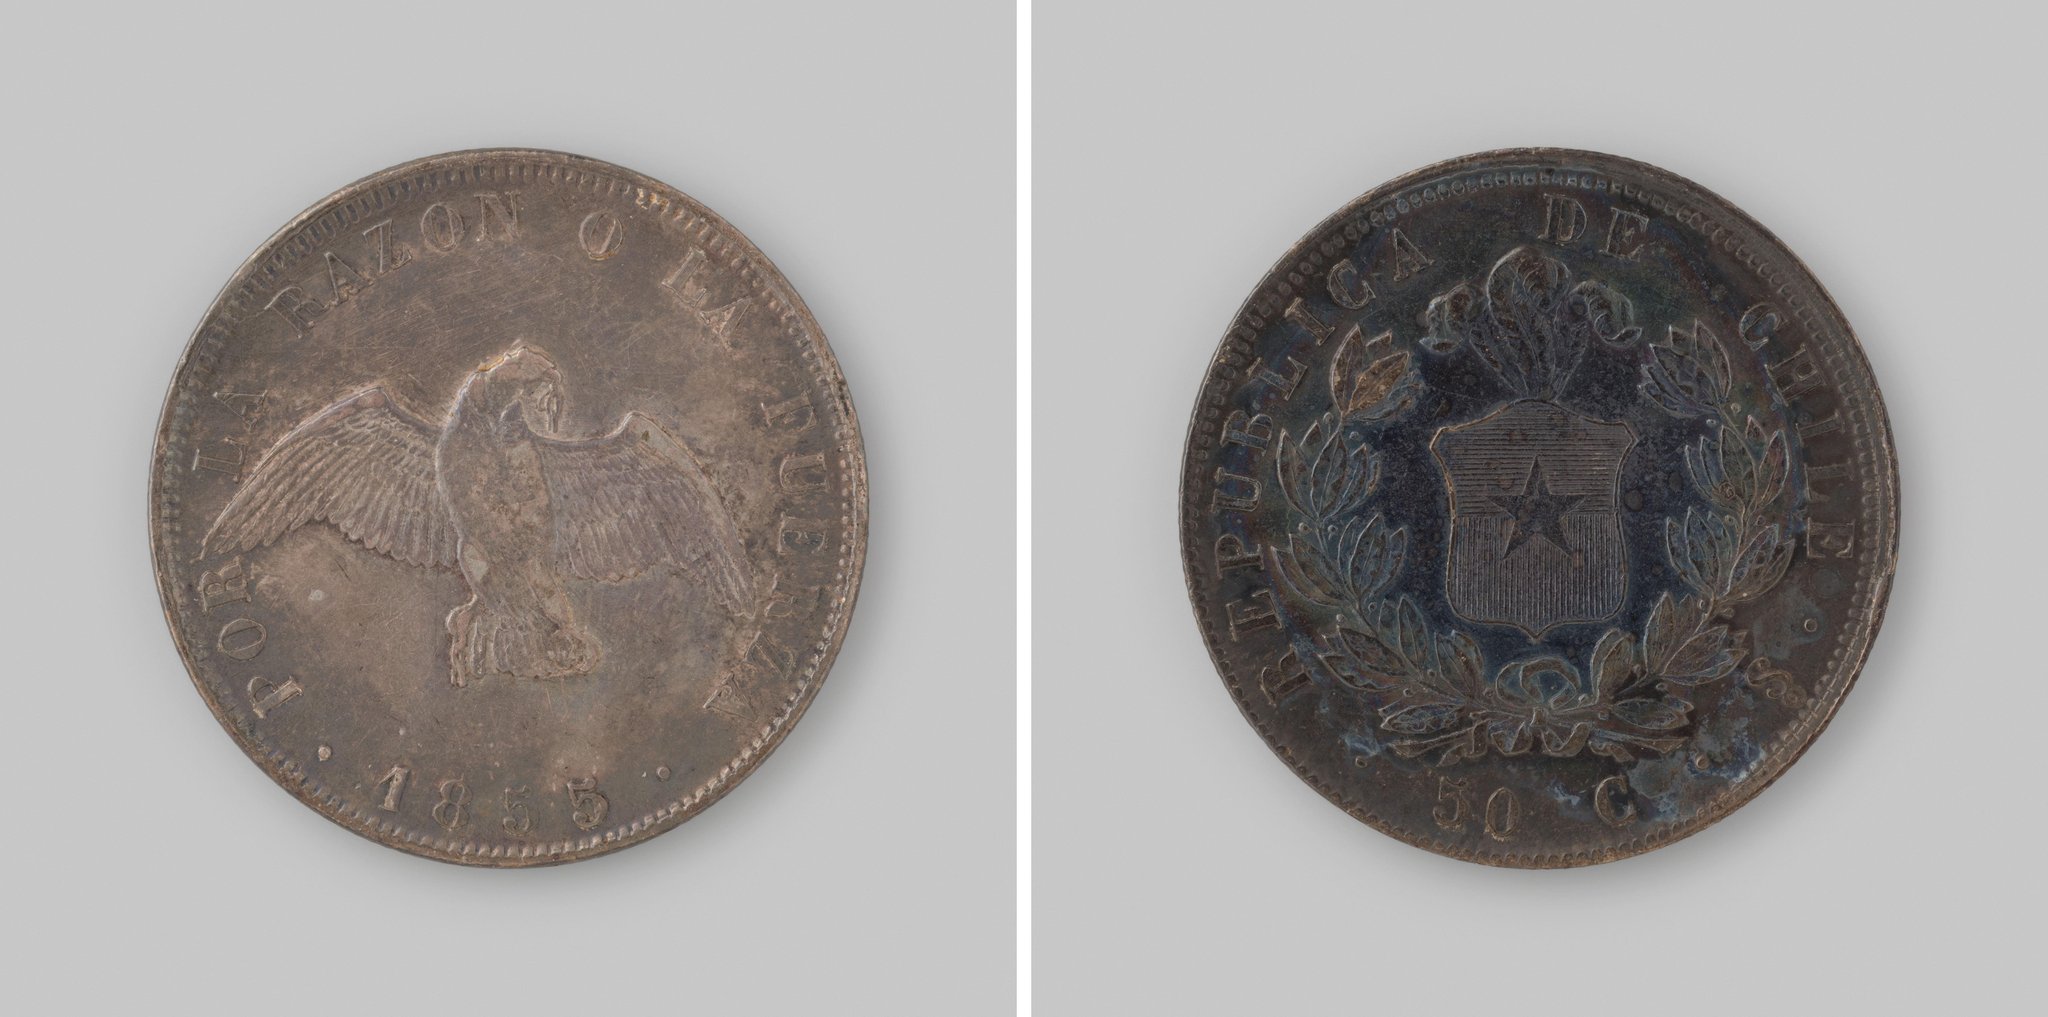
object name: coin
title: Halve peso of vijftig centavos (vier reaal) uit Chili, 1855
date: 1855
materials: silver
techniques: striking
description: Zilveren munt. Voorzijde: omkijkende adelaar, vliegend naar links. Jaartal onderaan. Keerzijde: tussen twee samengebonden takken wapenschild, waarop pluim. Waarde-aanduiding: 50 C. onderaan. Kartelrand.